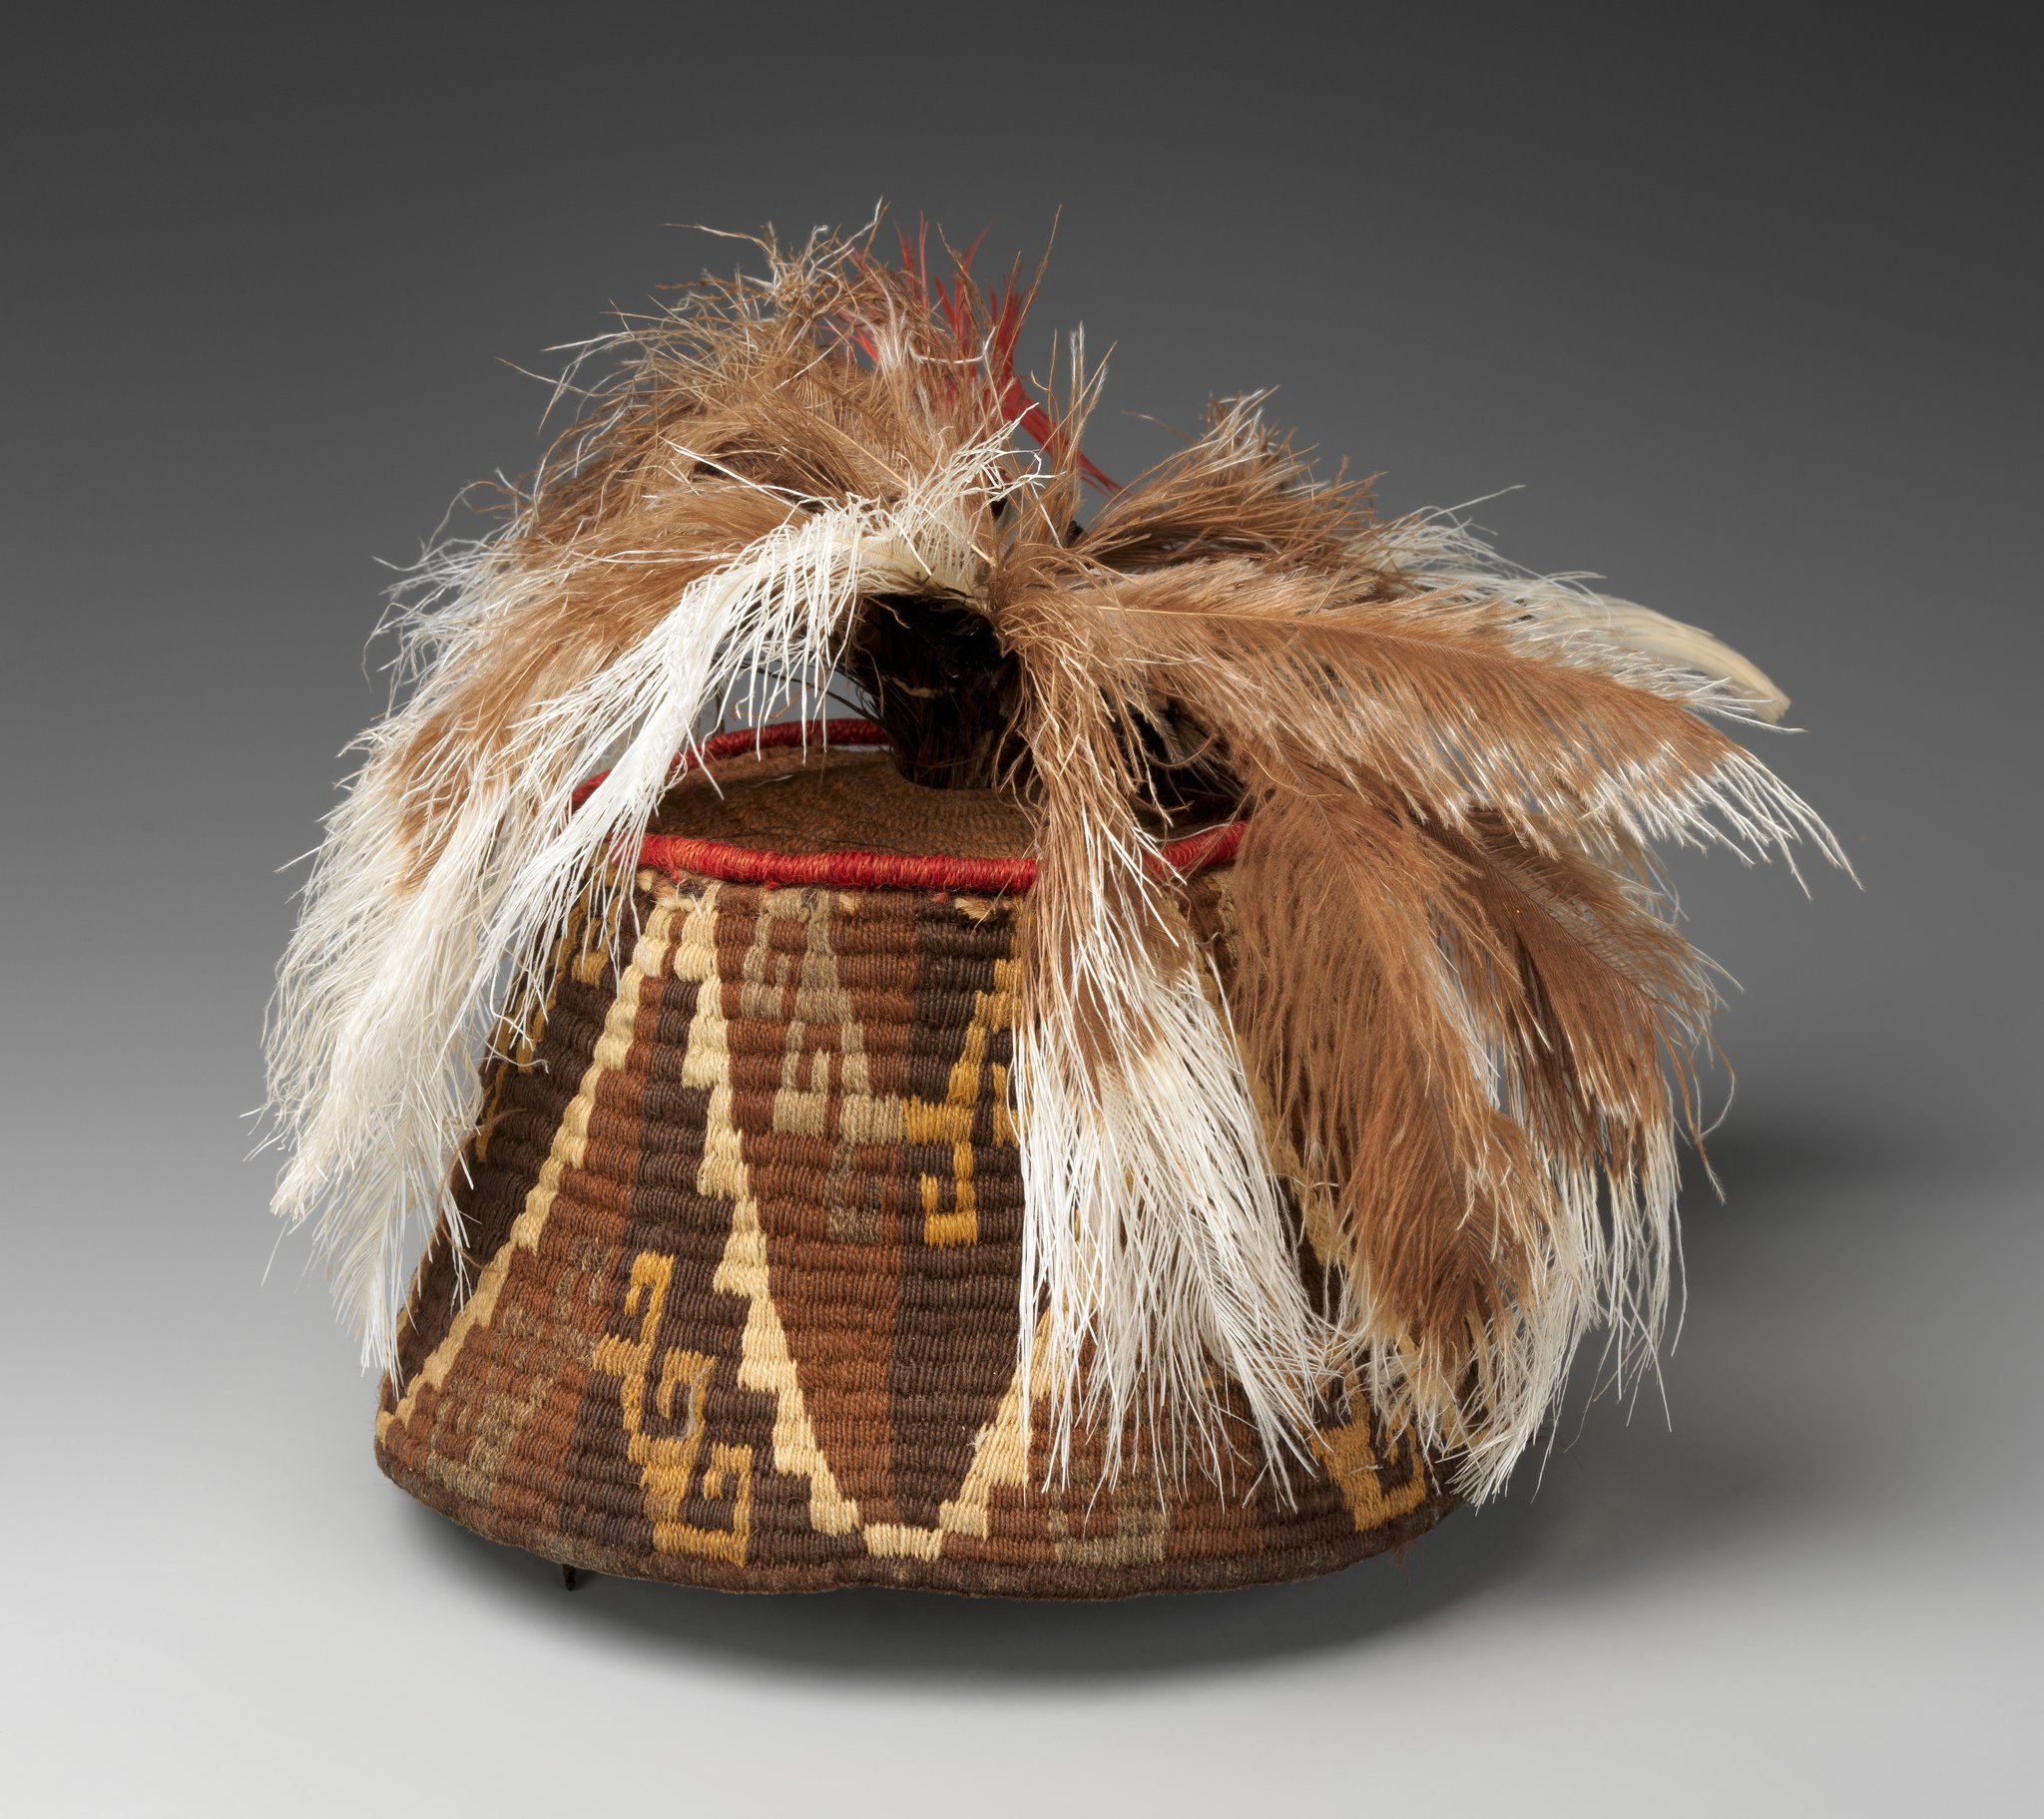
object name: hat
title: Cap with Feathers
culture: arica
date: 901-1400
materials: feather, wool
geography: chile